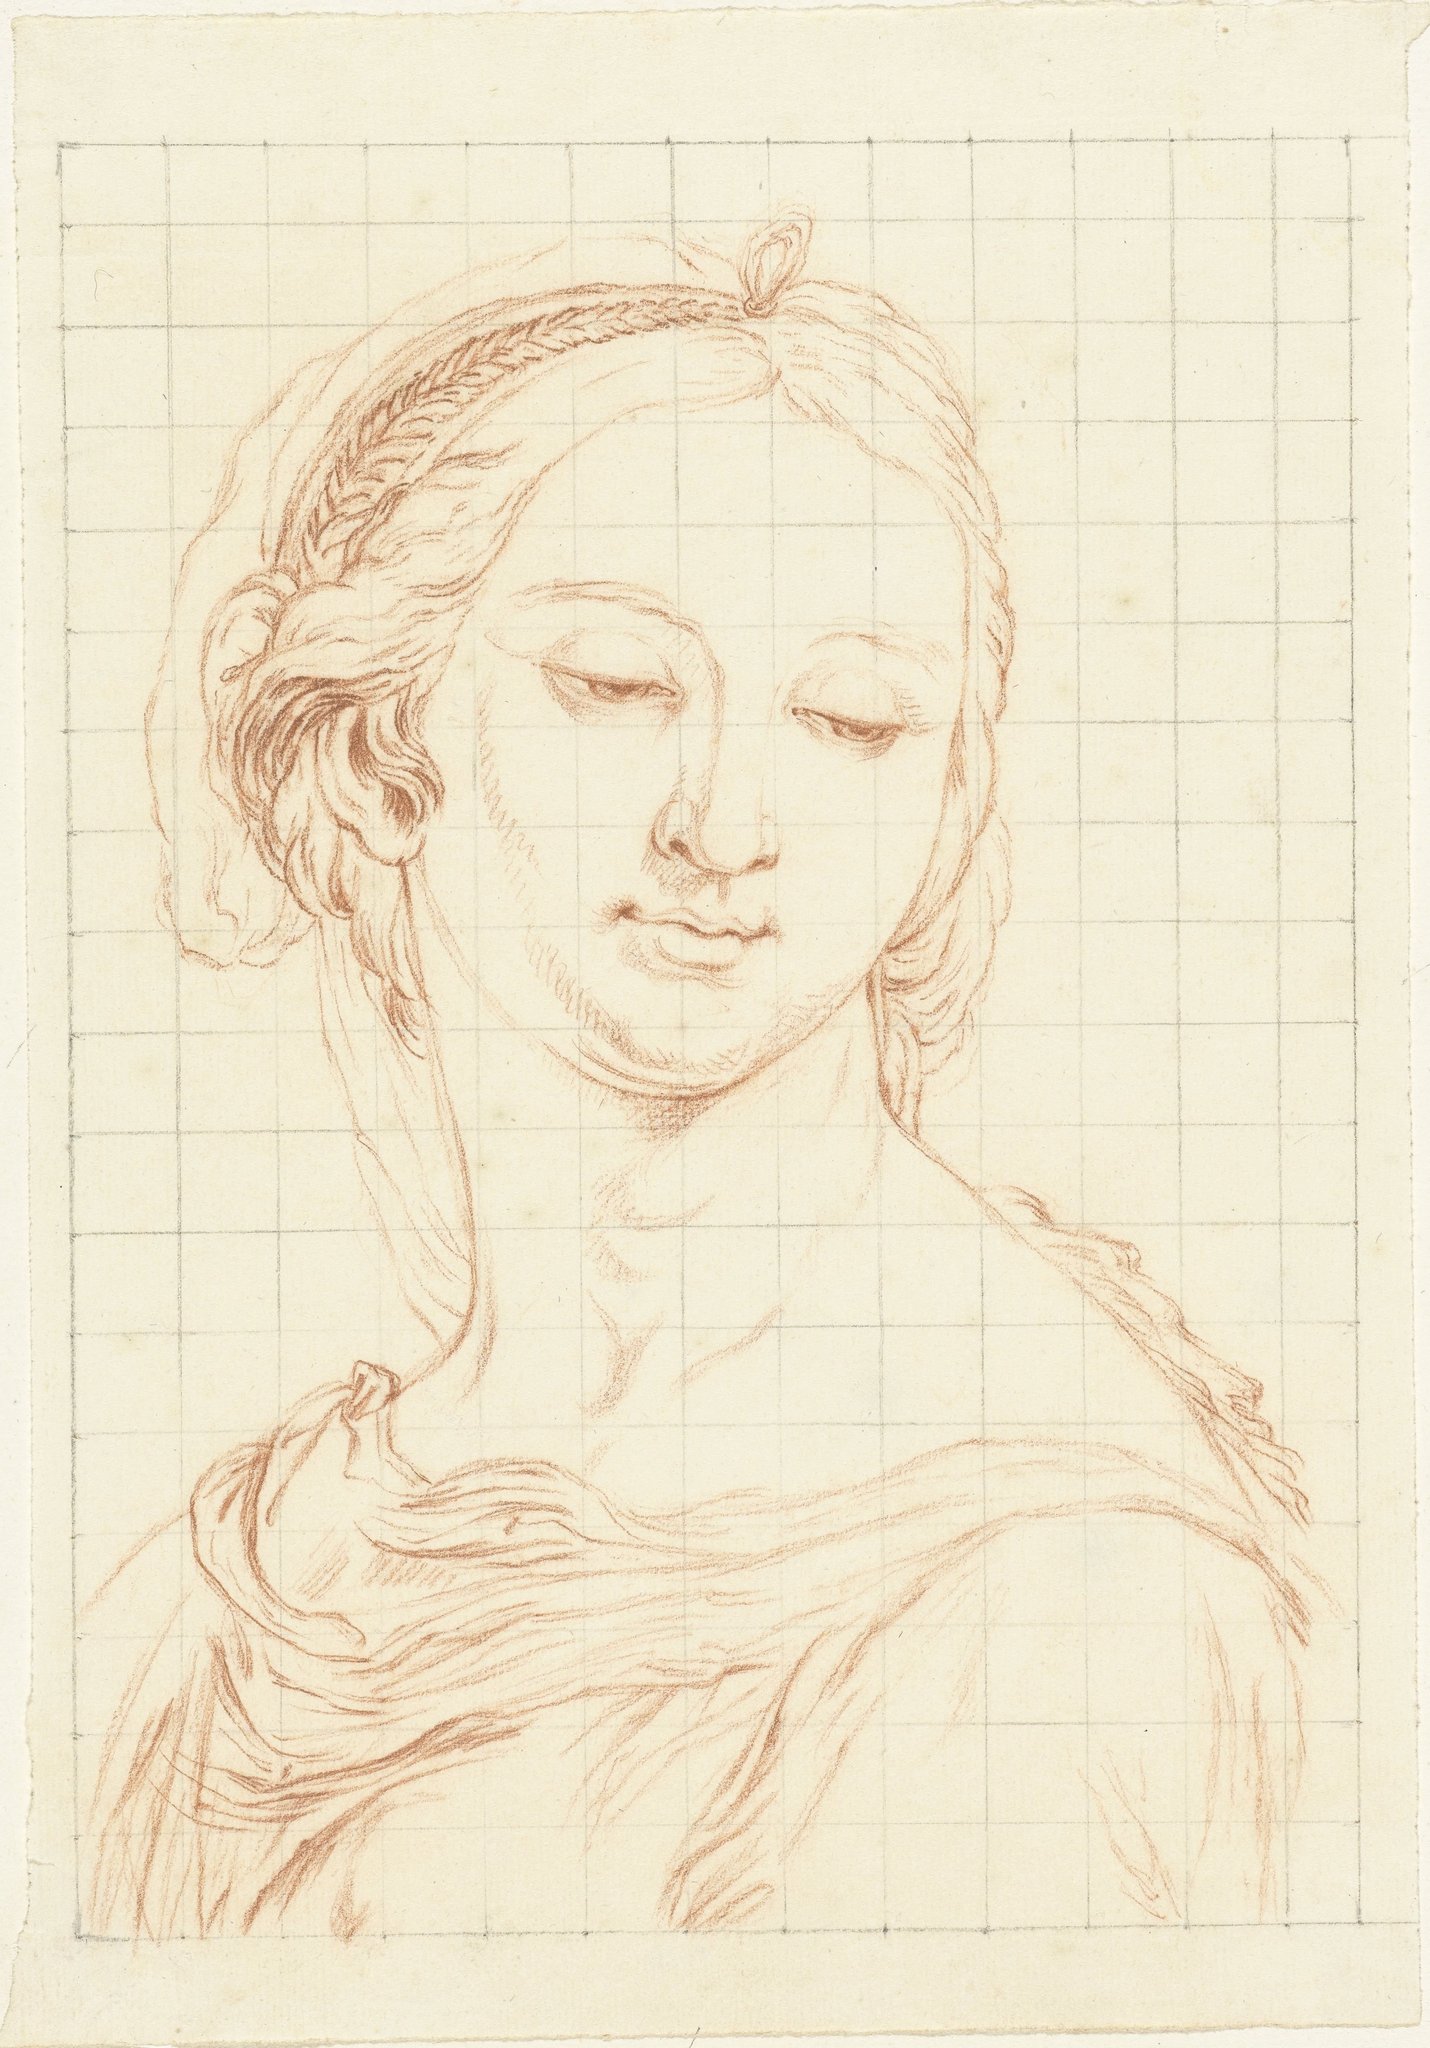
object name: drawing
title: Hoofd van Madonna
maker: bernard picart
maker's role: draughtsman, print maker, publisher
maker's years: 1673-1733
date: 1683-1733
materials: chalk, paper, pencil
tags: mary (without the christ-child)